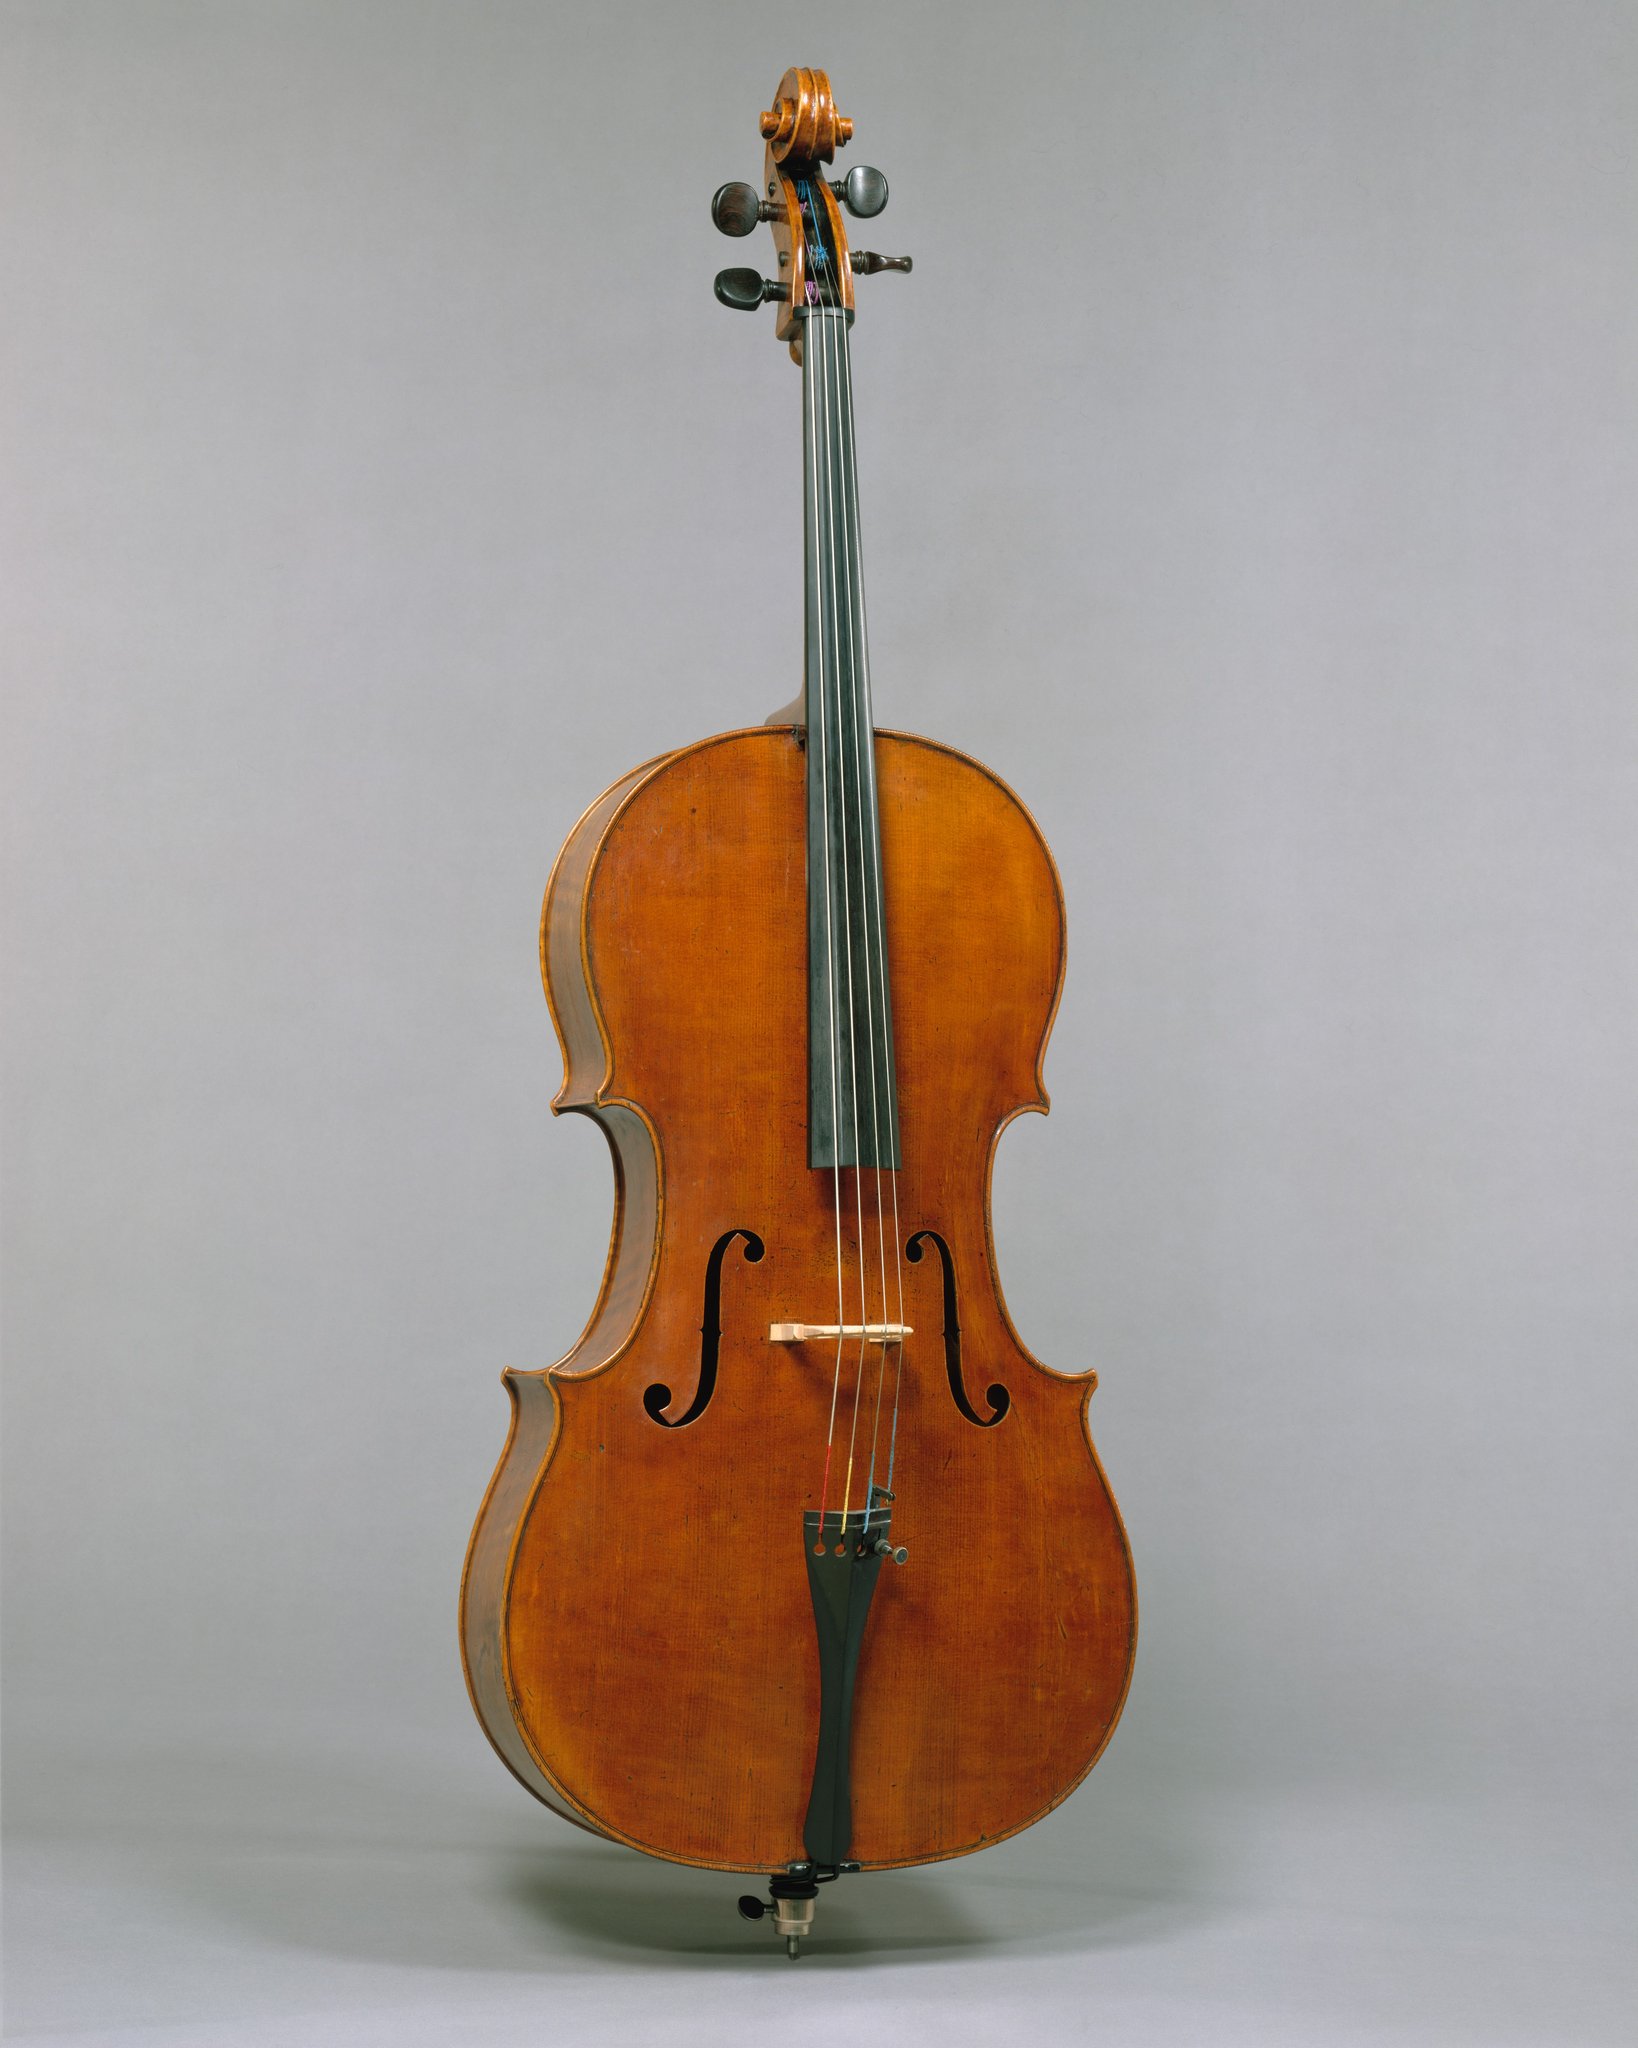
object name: violoncello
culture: french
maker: françois-louis pique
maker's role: maker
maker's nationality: french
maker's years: 1757-1822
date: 1800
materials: wood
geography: france